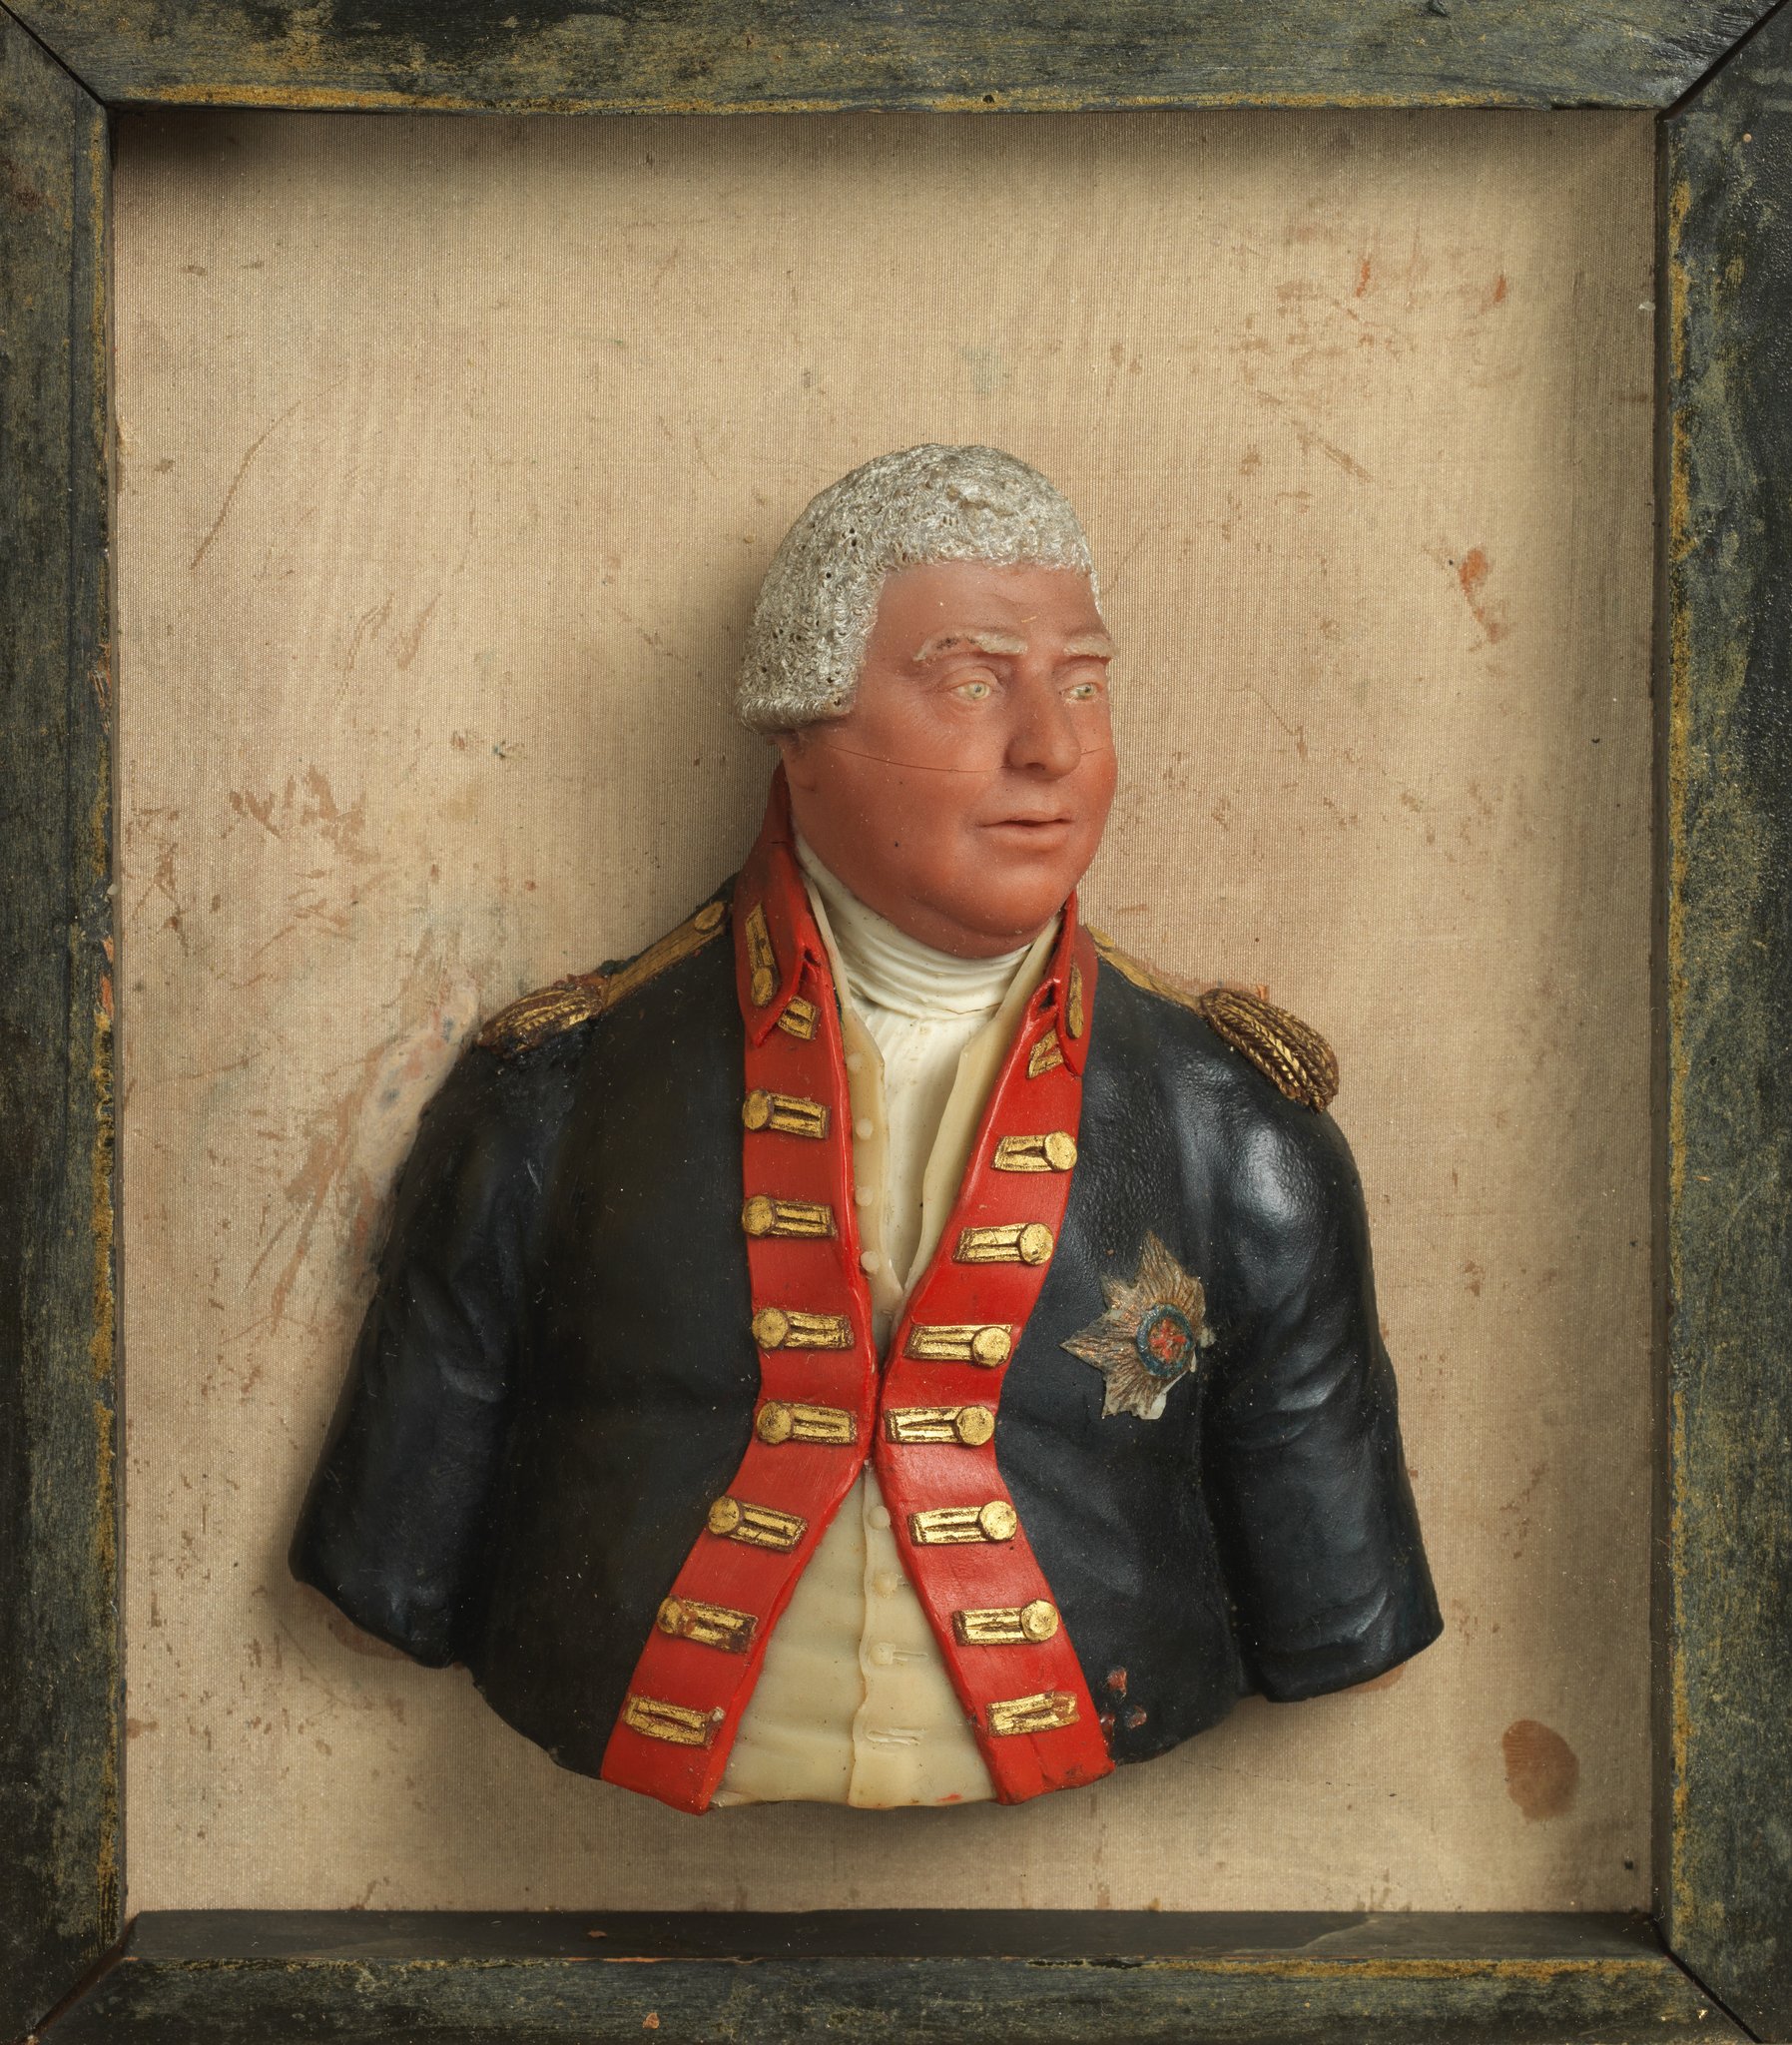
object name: medallion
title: George III (1738–1820), King of England (1760–1820)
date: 1801-1900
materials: glass, gold, silk, wax, wood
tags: kings,portraits